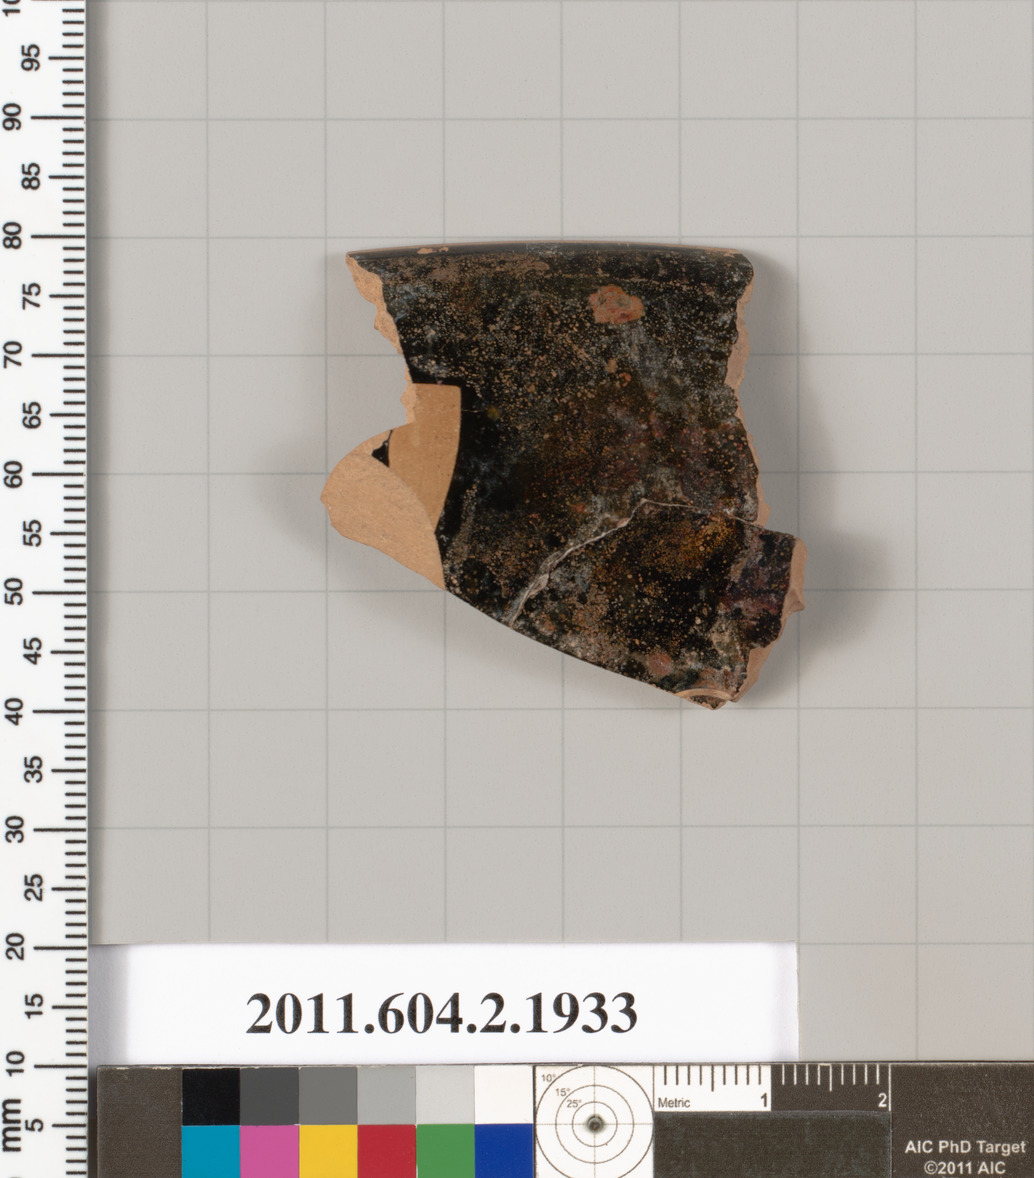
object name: skyphos fragment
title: Terracotta rim fragment of a skyphos (deep drinking cup)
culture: greek, attic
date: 500-401 BCE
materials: terracotta